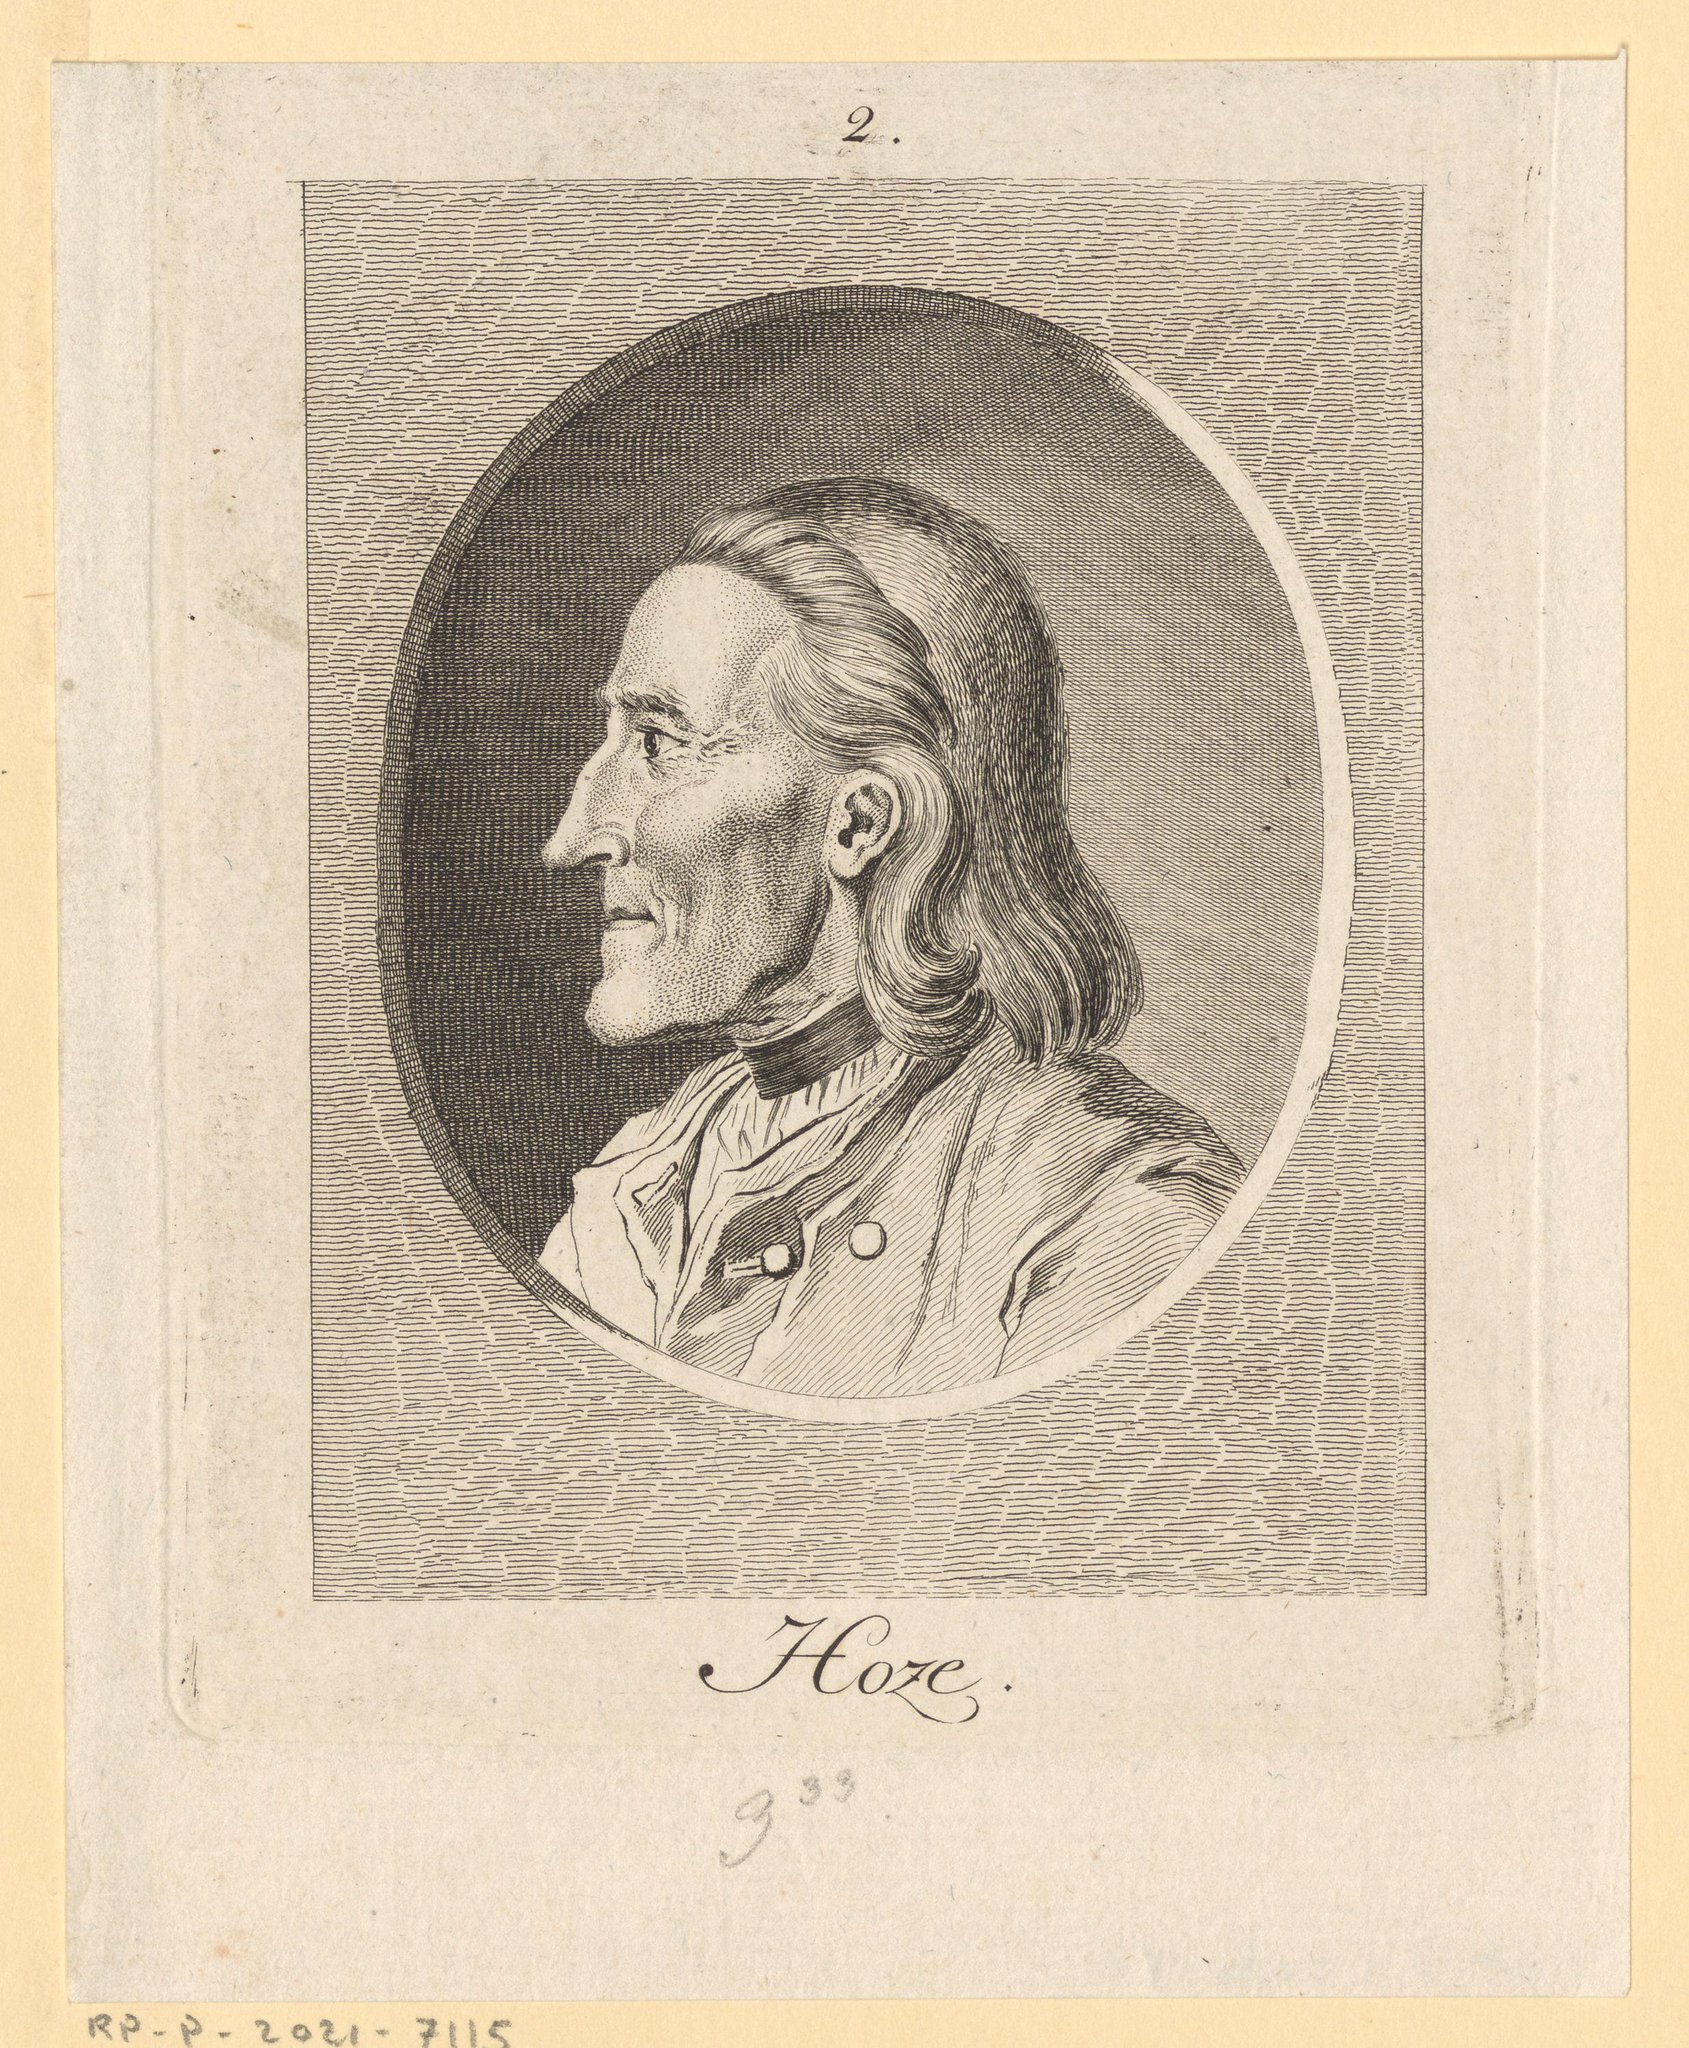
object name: print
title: Portret van een man aangeduid als Hoze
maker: Anonymous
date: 1775-1799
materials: paper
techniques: engraving, etching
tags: historical persons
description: Mogelijk Friedrich von Hotze (1739-1799). Midden boven genummerd: 2.